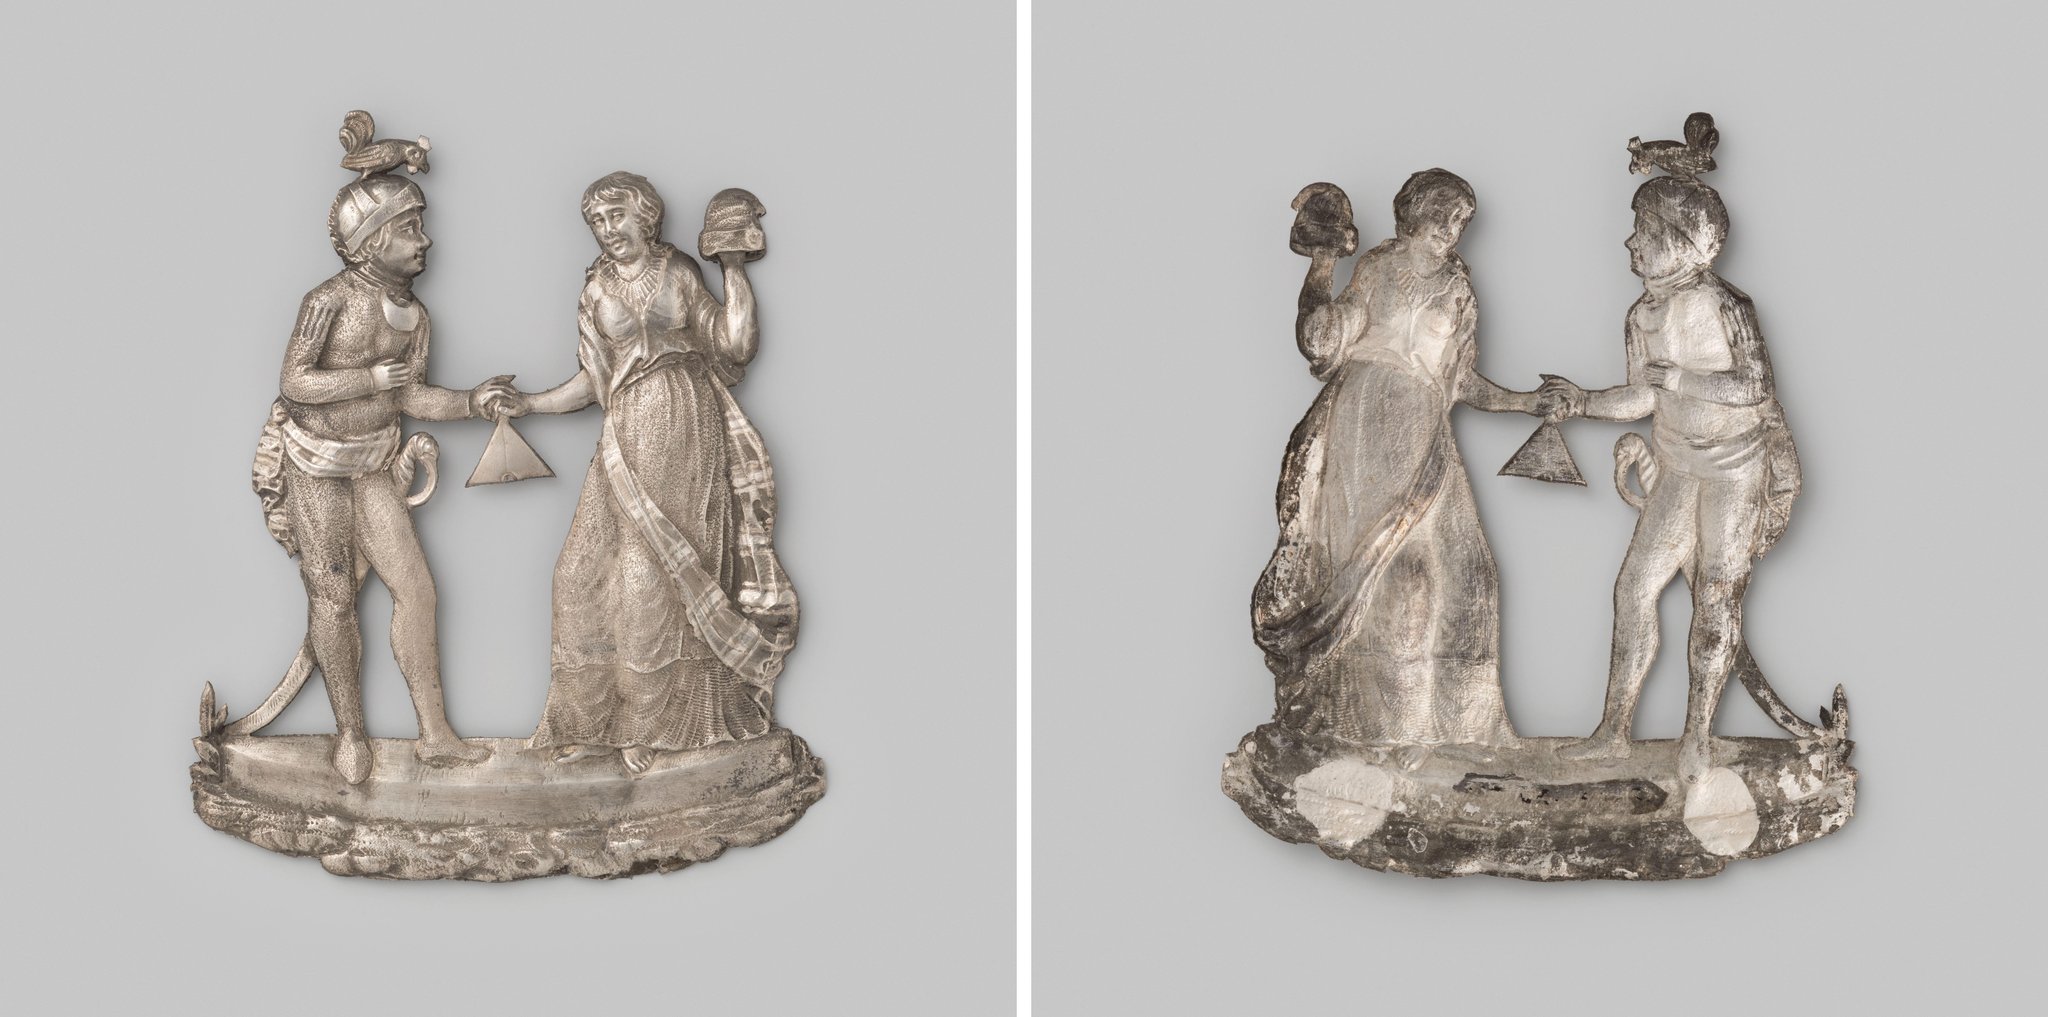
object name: plaque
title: Omwenteling te Amsterdam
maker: Anonymous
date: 1795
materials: silver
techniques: painted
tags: amsterdam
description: eenzijdige, gedeeltelijk beschilderde plaquette. Voorzijde: gehelmde man met haan op hoofd, voorstellende Franse sans-culotte, houdt zijn rechterhand op zijn hart, en met zijn linkerhand houdt hij paslood vast, samen met tegenover hem staande vrouw, die in geheven rechterhand vrijheidsmuts houdt; op voetstuk opschrift. Keerzijde: blanco.